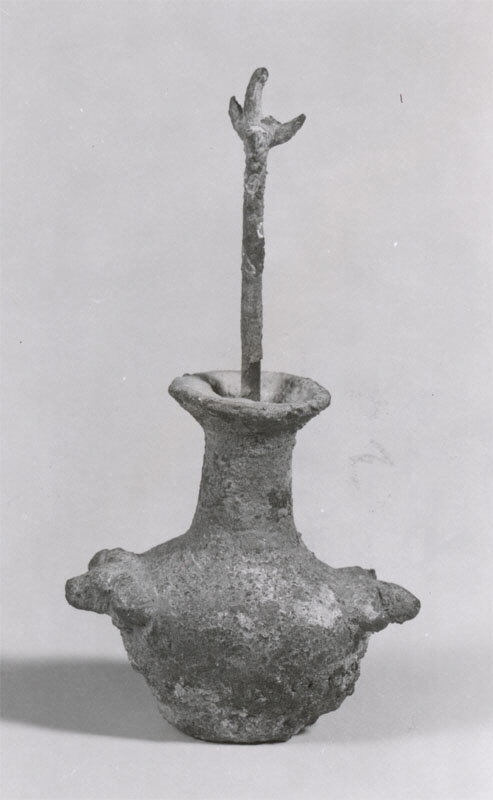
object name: cosmetic container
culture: bactria-margiana archaeological complex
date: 2333-1668 BCE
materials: copper alloy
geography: bactria-margiana